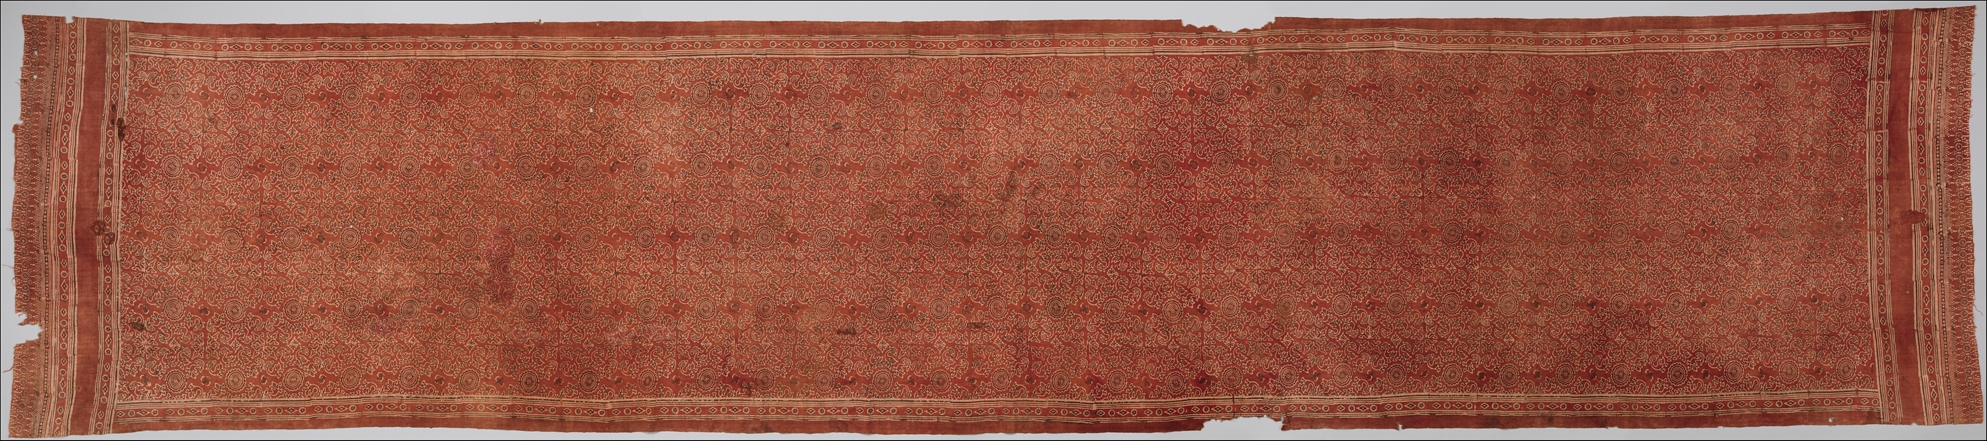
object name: textile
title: Textile with Sacred Goose (Hamsa) Design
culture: indian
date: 1401-1533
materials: cotton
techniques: dyeing, printing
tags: birds